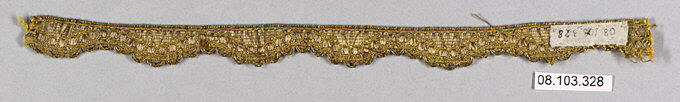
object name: galloon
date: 1701-1800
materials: metal thread, silk